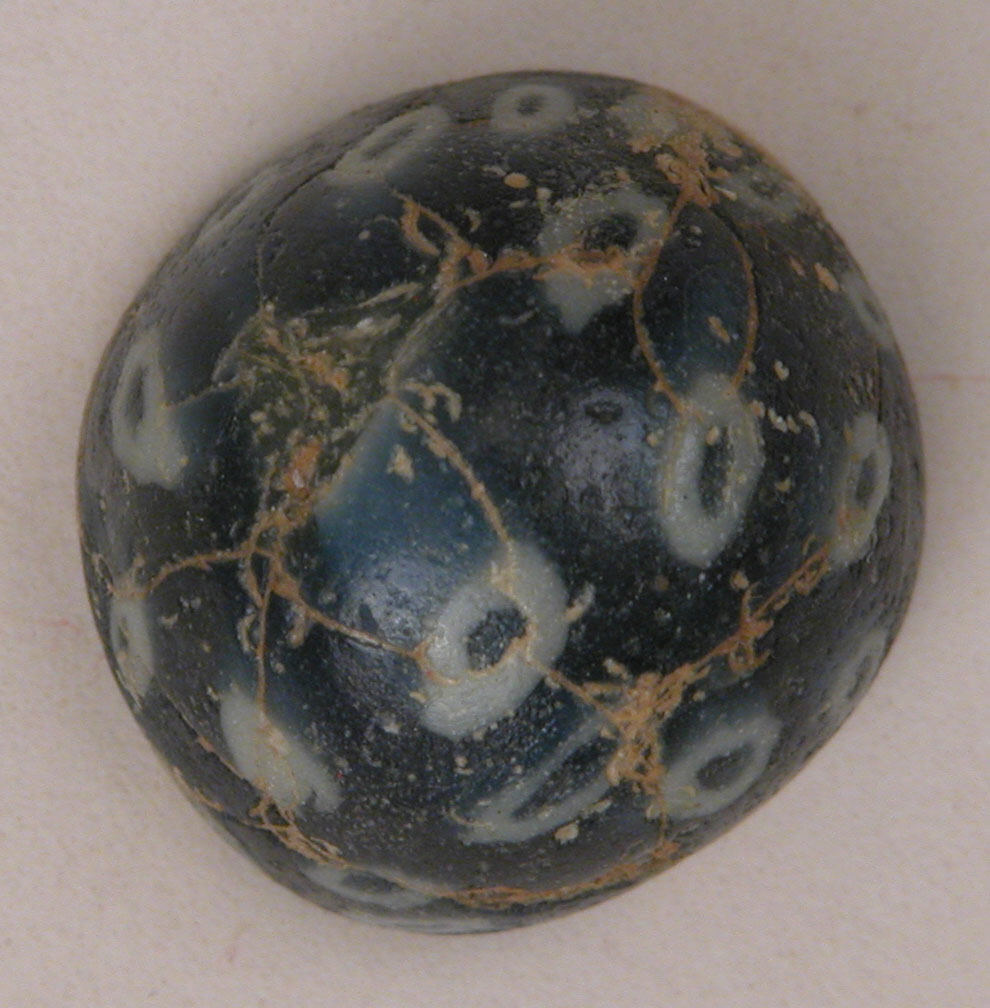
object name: gaming piece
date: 701-1200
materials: glass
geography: islamic lands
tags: games